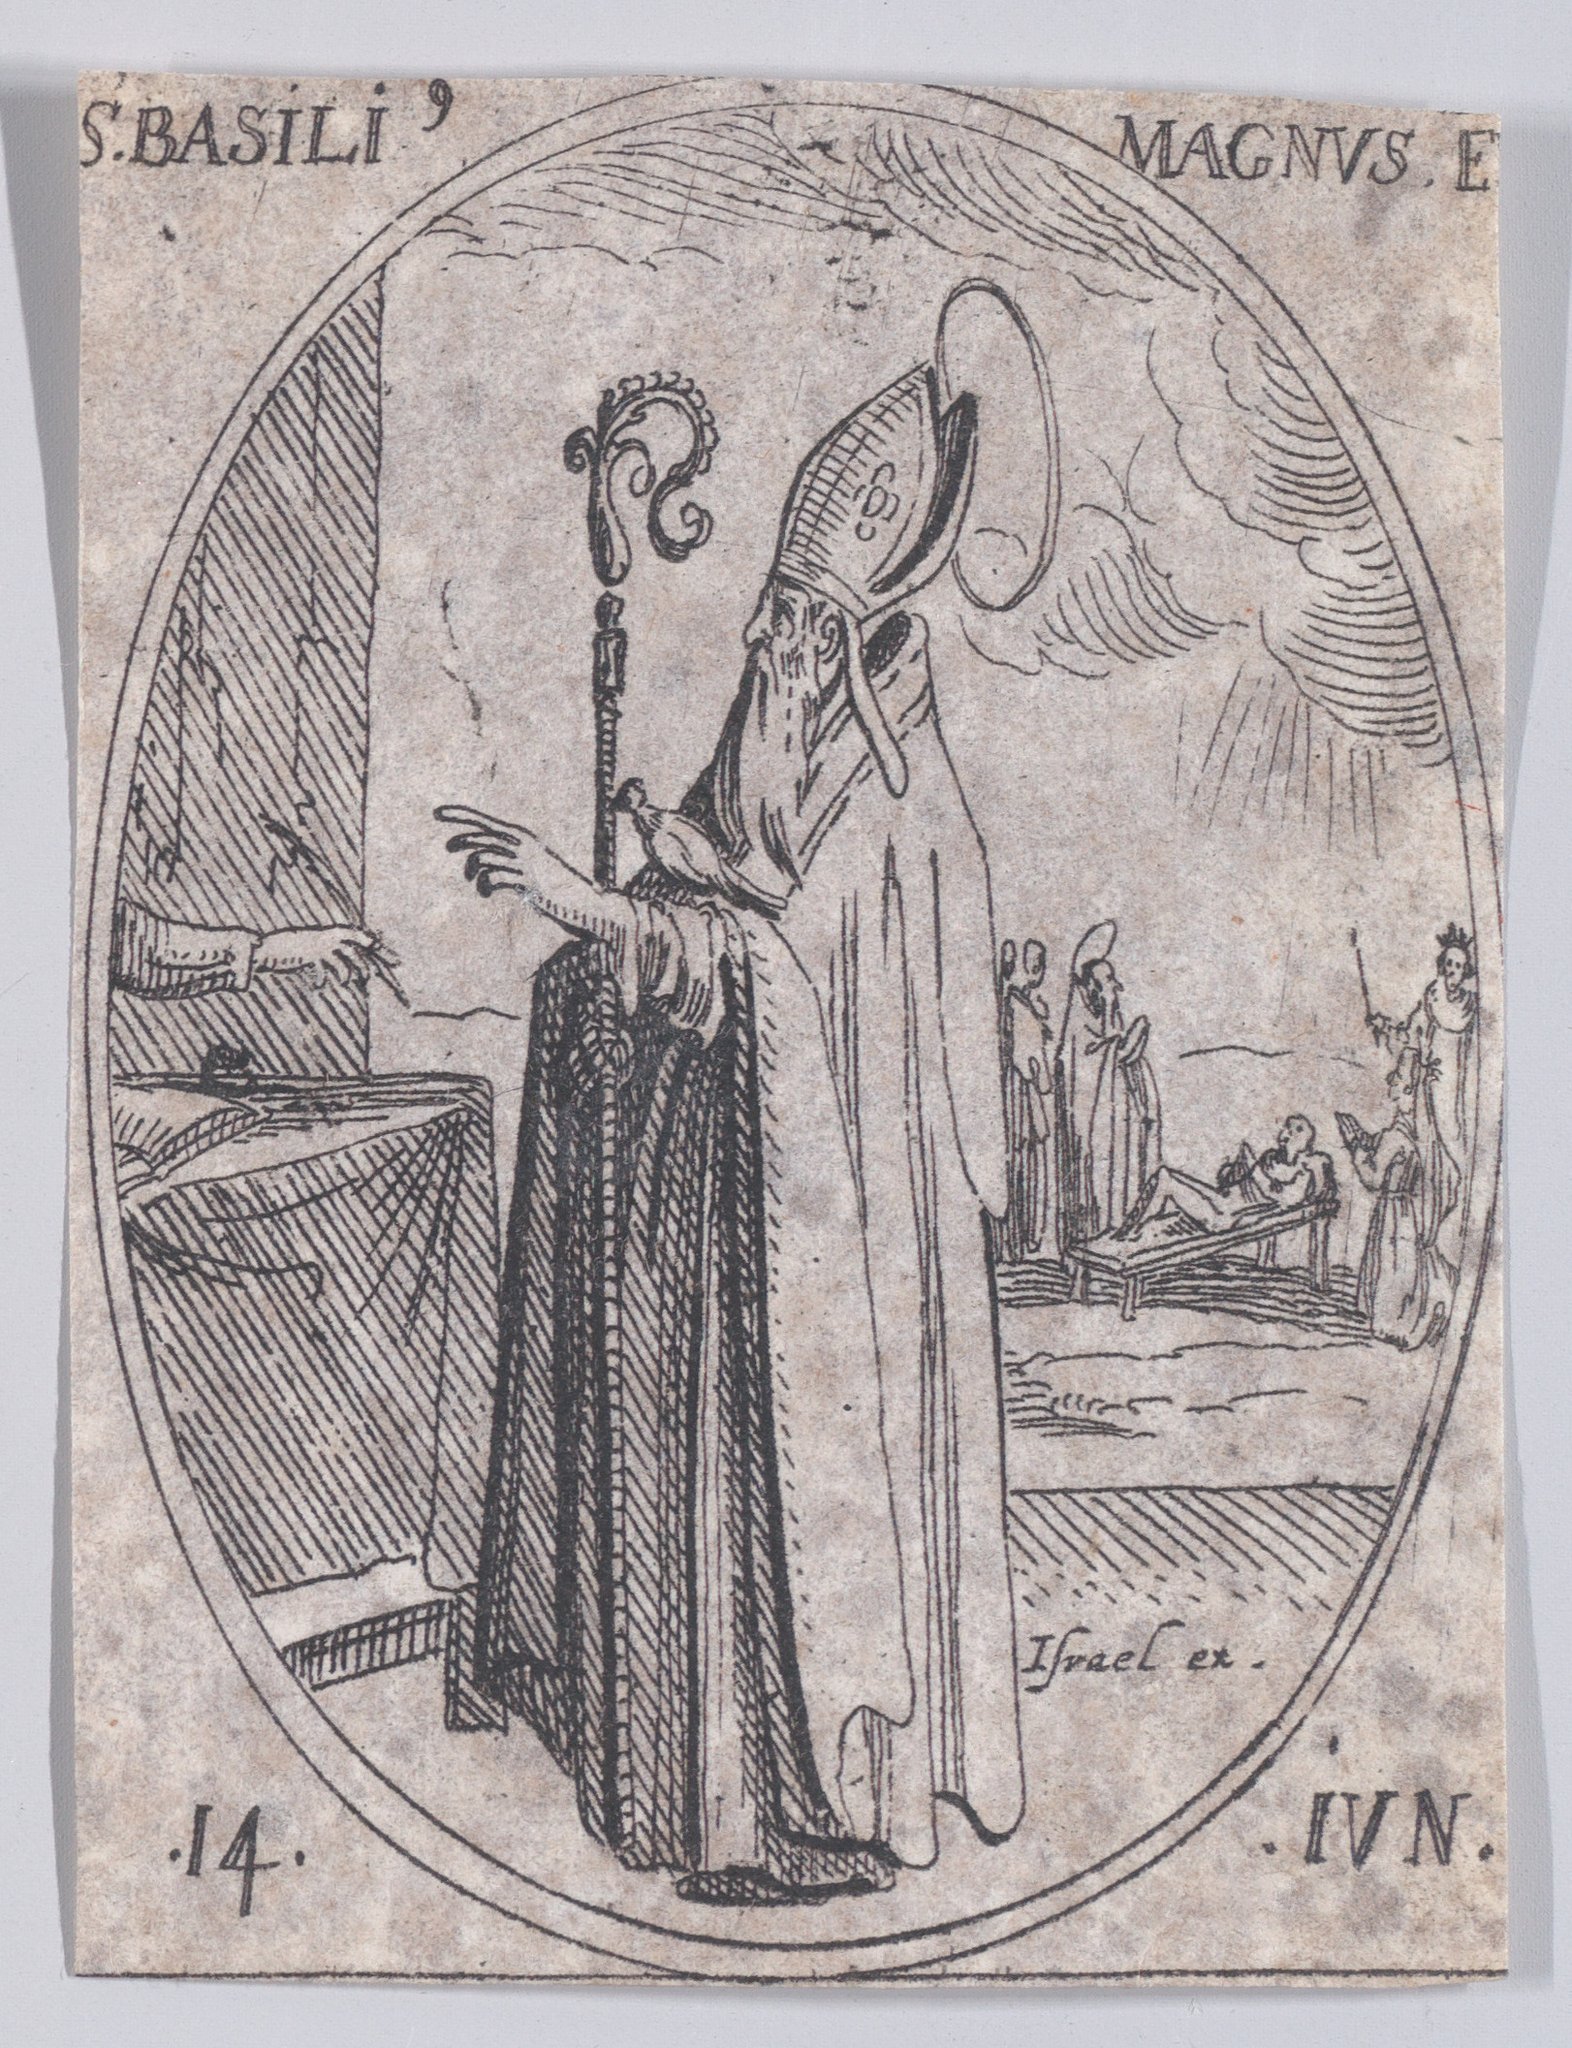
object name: print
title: S. Basile le Grand, évêque (St. Basil the Great, Bishop), June 14th, from "Les Images De Tous Les Saincts et Saintes de L'Année" (Images of All of the Saints and Religious Events of the Year)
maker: jacques callot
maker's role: artist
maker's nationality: french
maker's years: 1592-1635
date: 1636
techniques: etching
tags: men,saints